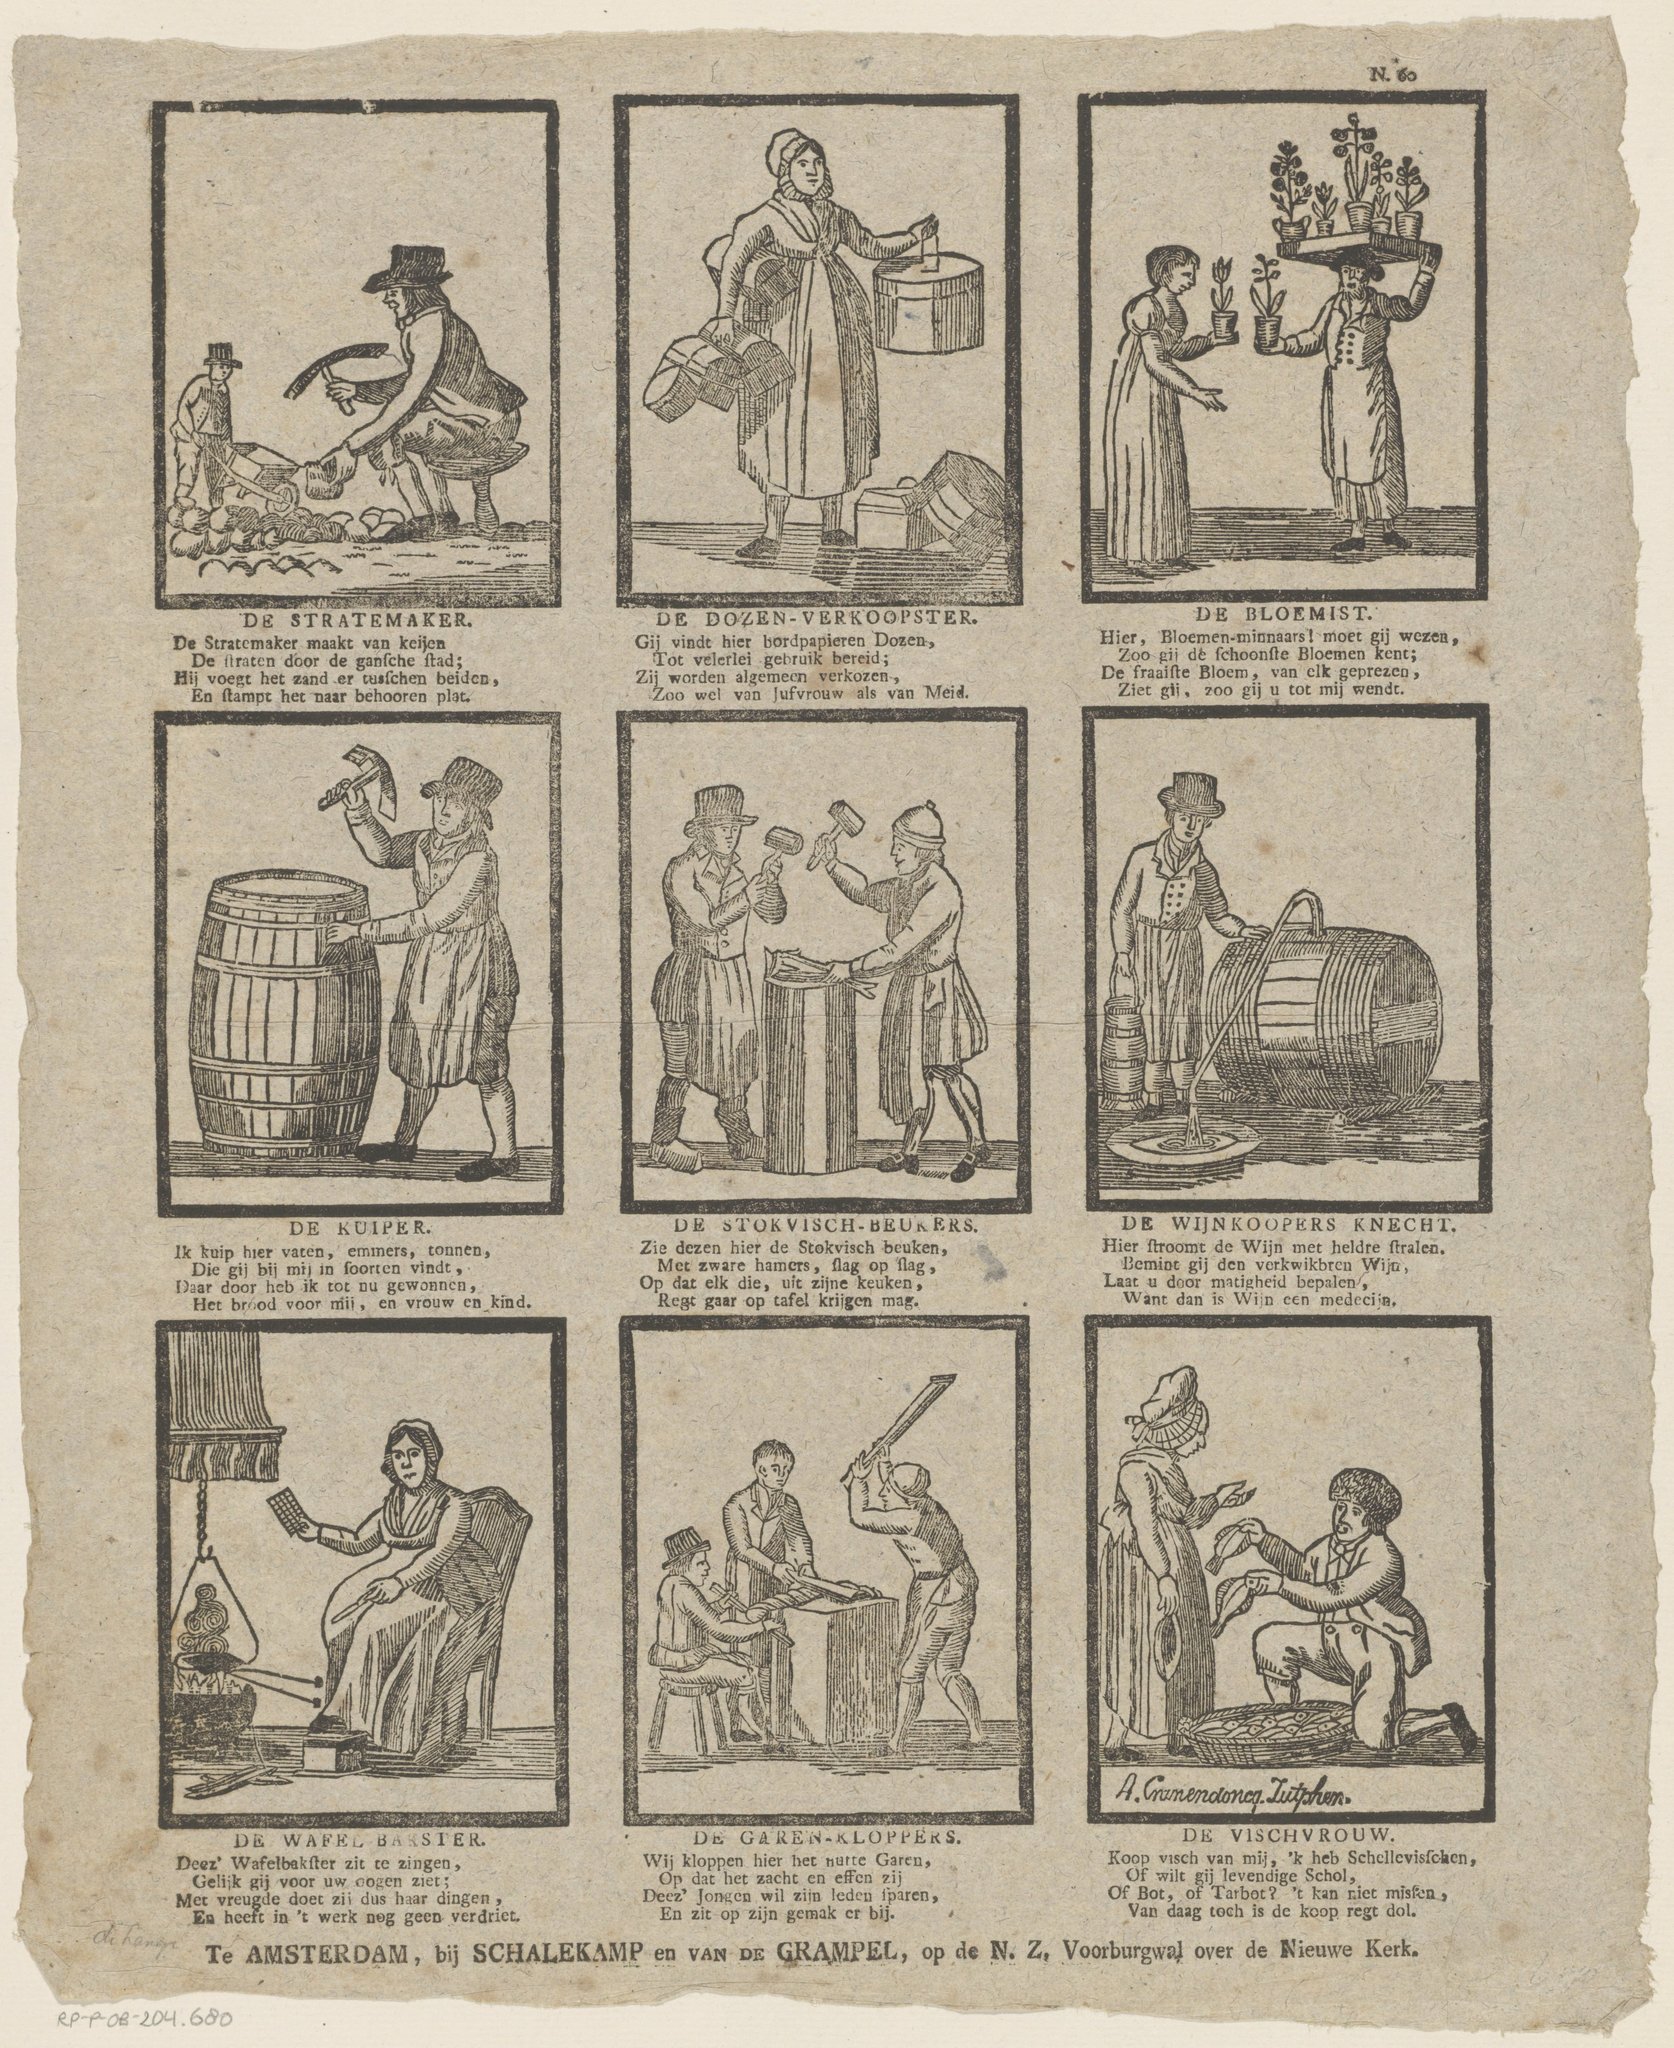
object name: print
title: Ambachten en beroepen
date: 1822-1849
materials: paper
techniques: letterpress printing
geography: amsterdam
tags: craft-production, skilled handiwork, working class, labourers, street-trader, crafts and industries, merchant, salesman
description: Blad met 9 voorstellingen van ambachtslieden en beroepen, zoals stratenmaker, dozenverkoopster en bloemist. Onder elke afbeelding een titel en een vierregelig vers. Genummerd rechtsboven: N. 60.